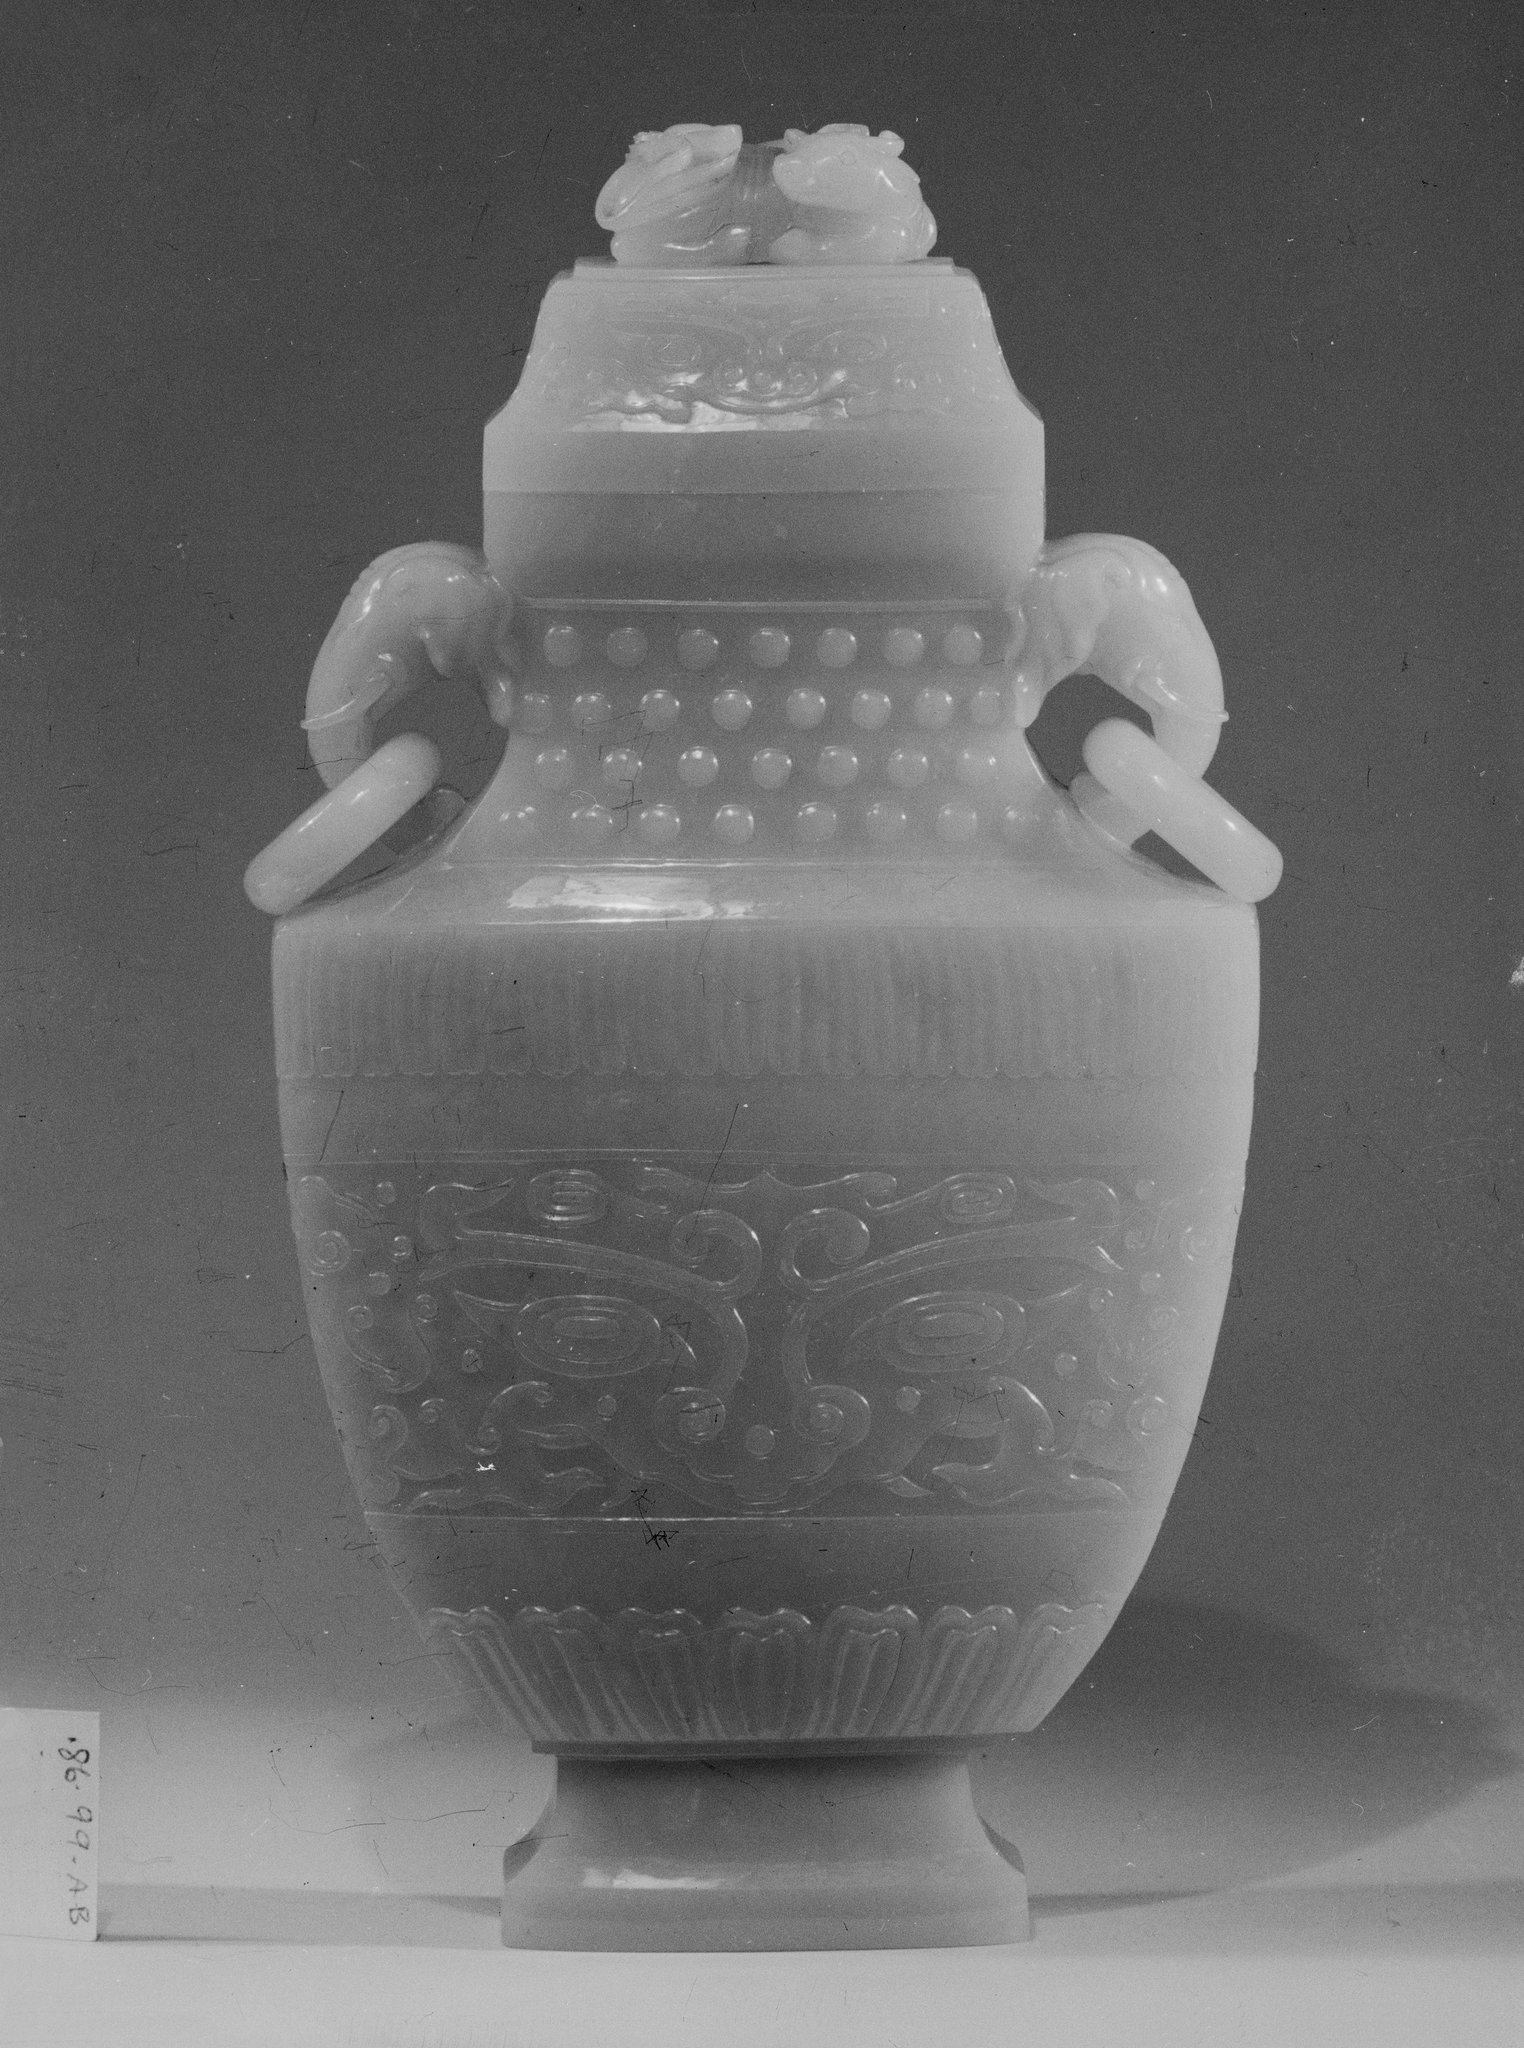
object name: covered vase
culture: chinese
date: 1701-1800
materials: jade